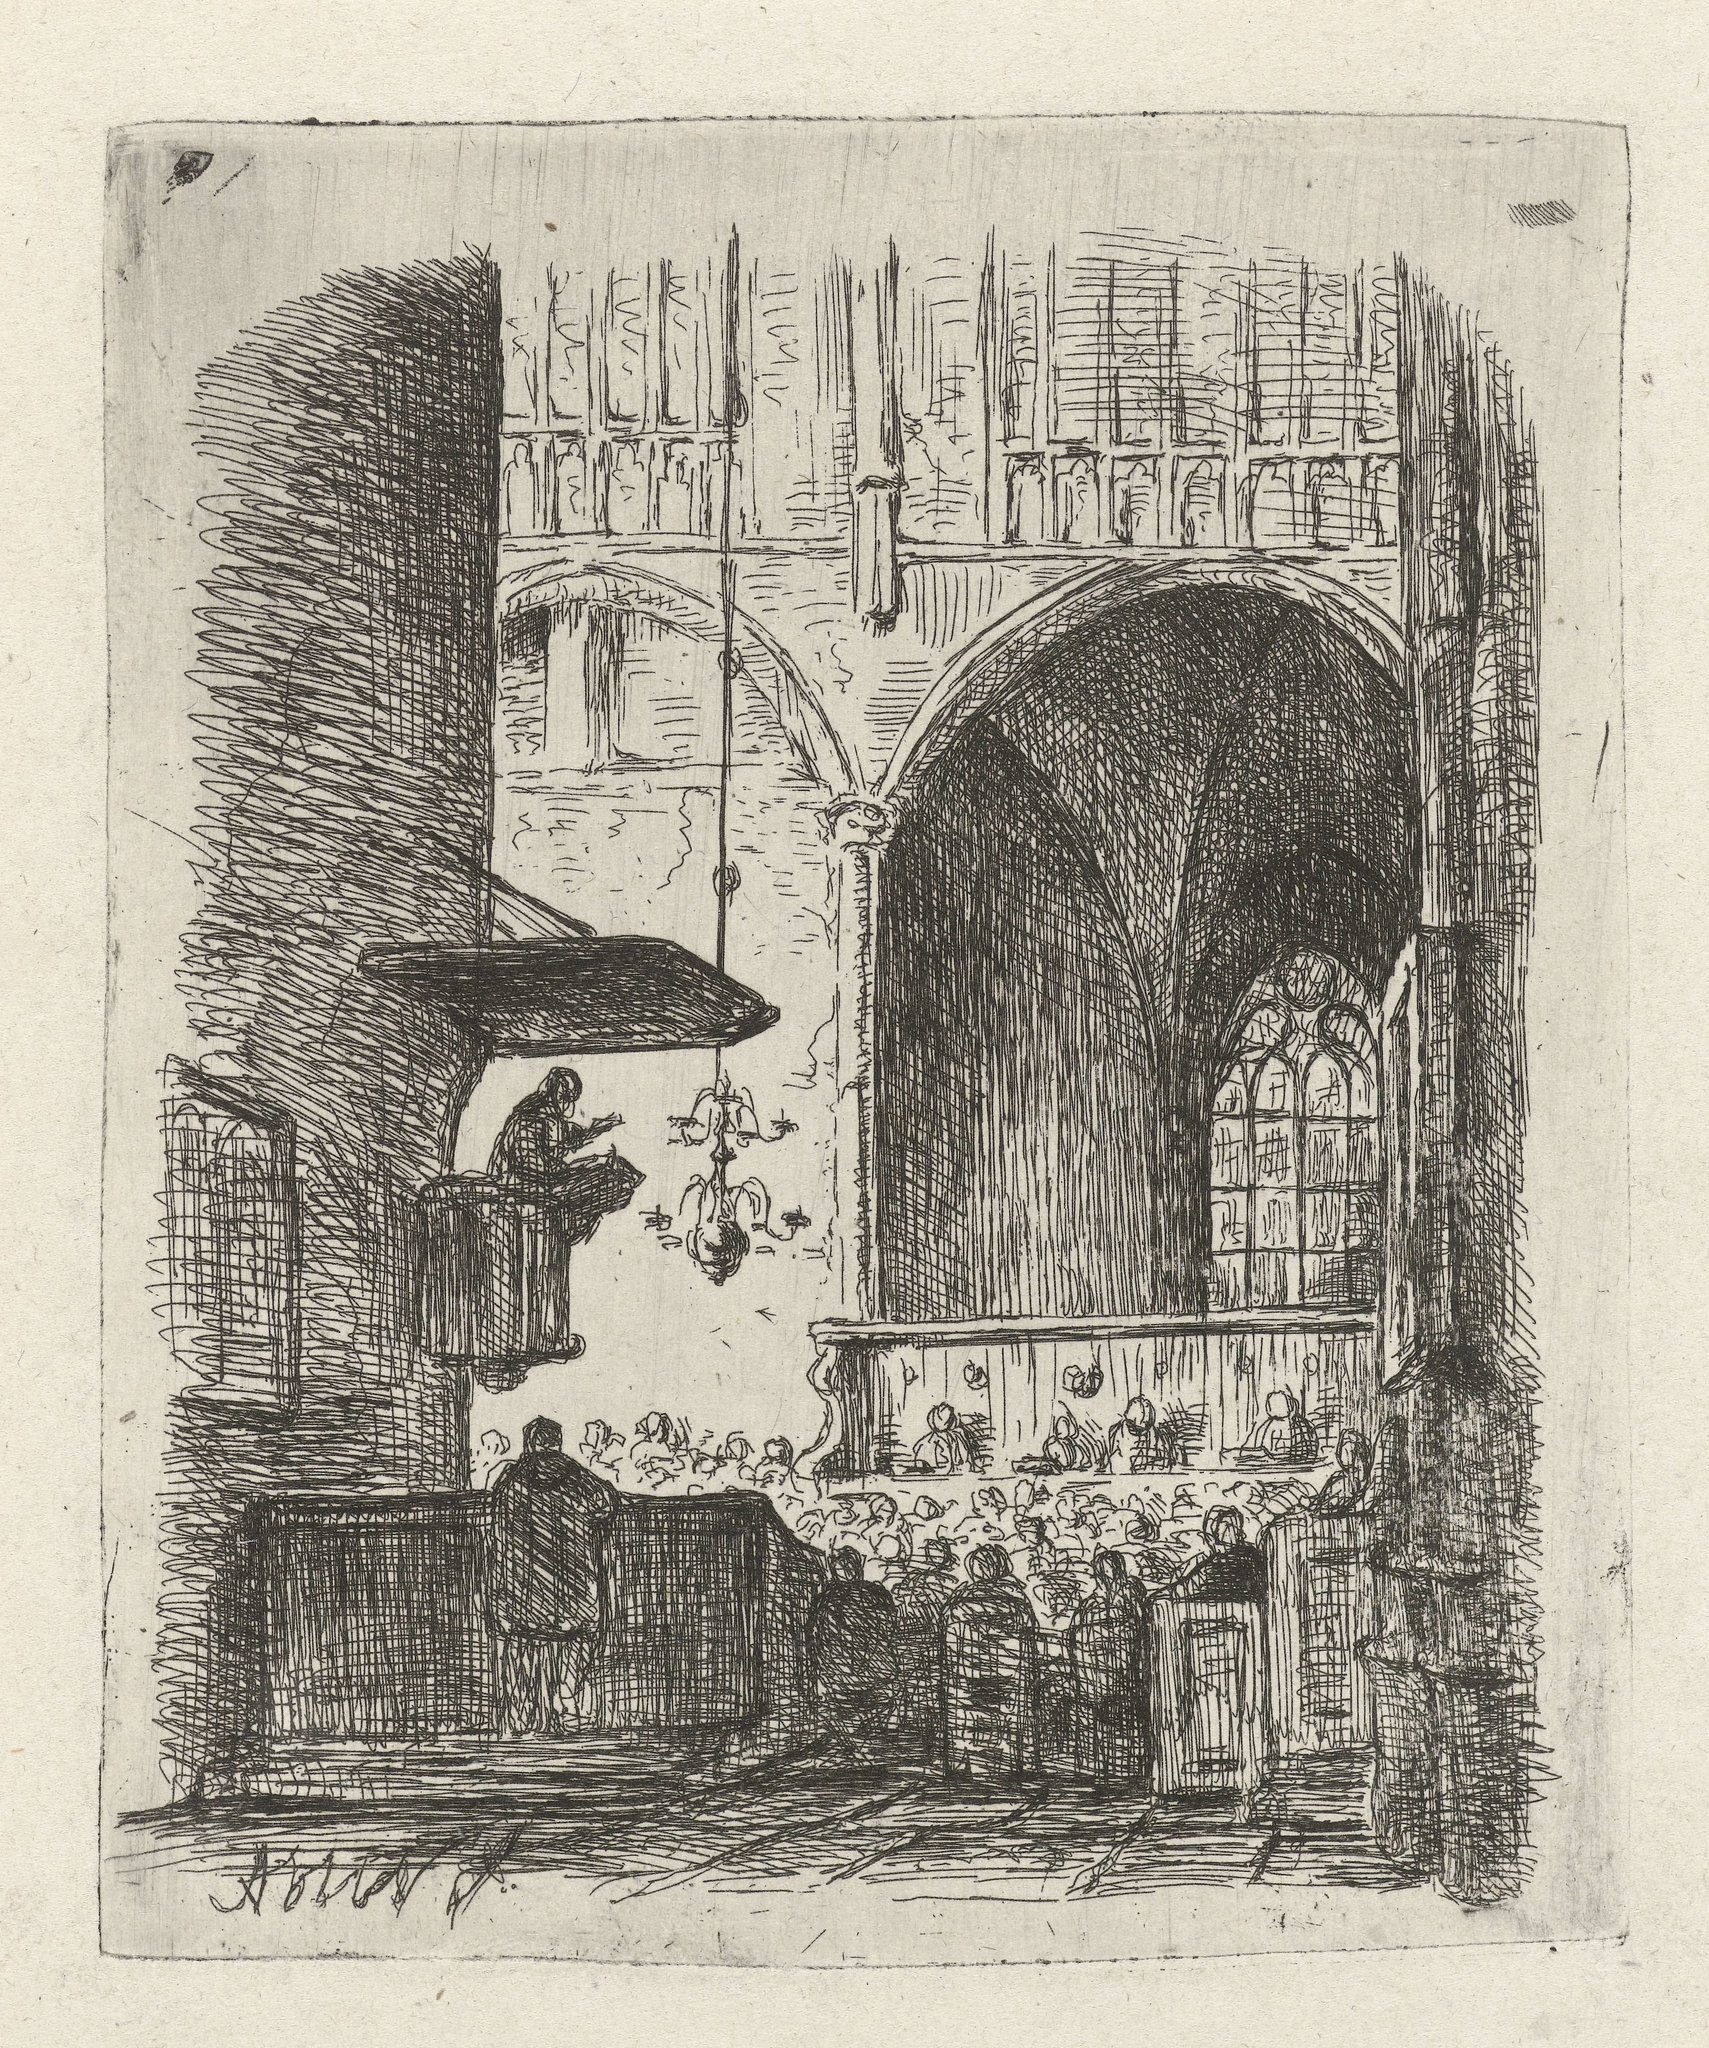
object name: print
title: Kerkinterieur met kerkdienst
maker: adrianus wilhelmus nieuwenhuyzen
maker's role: draughtsman, print maker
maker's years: 1814-1894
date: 1856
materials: paper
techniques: etching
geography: utrecht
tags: interior of church, sermon ~ protestant service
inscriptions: collector's mark: Lugt 2760, collector's mark: Lugt 2228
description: Een kerkinterieur, waarbij links op de preekstoel een predikant staat. De kerkbanken zijn gevuld met toehoorders.